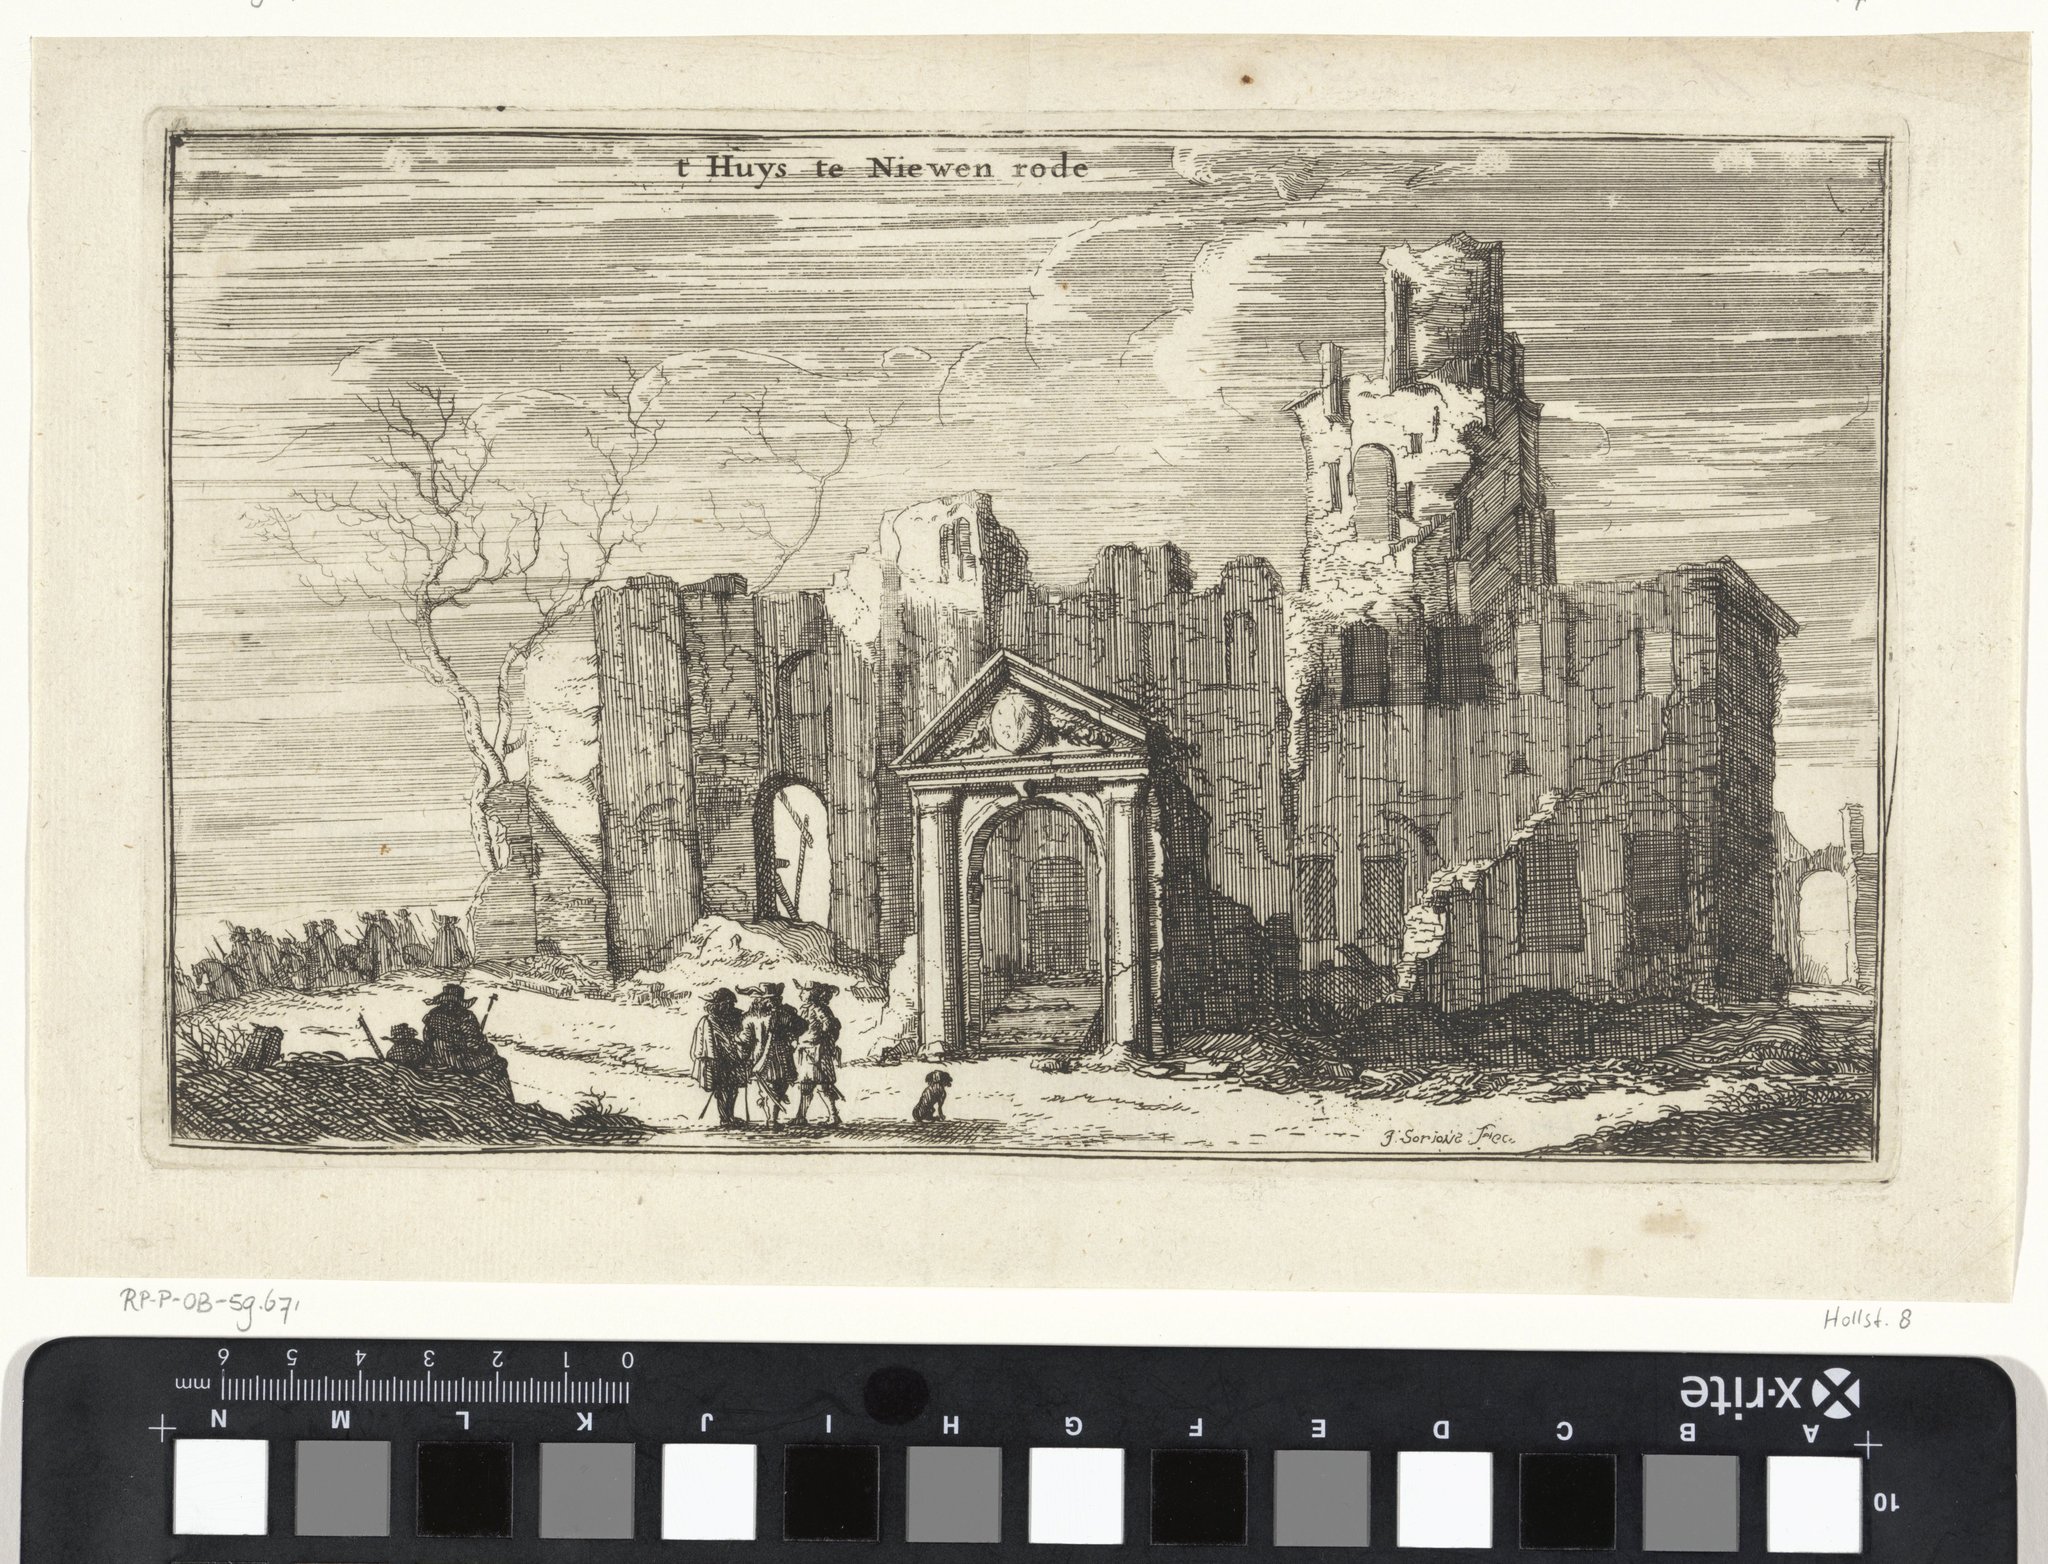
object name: history print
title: 't Huys te Niewen Rode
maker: isaac sorious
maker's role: print maker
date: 1672-1676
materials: paper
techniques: etching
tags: devastated, ruined place or city (~ warfare), rampjaar (disaster year)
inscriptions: collector's mark: Lugt 2228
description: Gebruikt als illustratie in: T. van Domselaer, Het Ontroerde Nederlandt, dl. II, Marcus Willemsz Doornick, Amsterdam 1676, p. 626/627. De reeks is ook als een losse serie uitgegeven met een titelprent die niet in het boek is opgenomen.